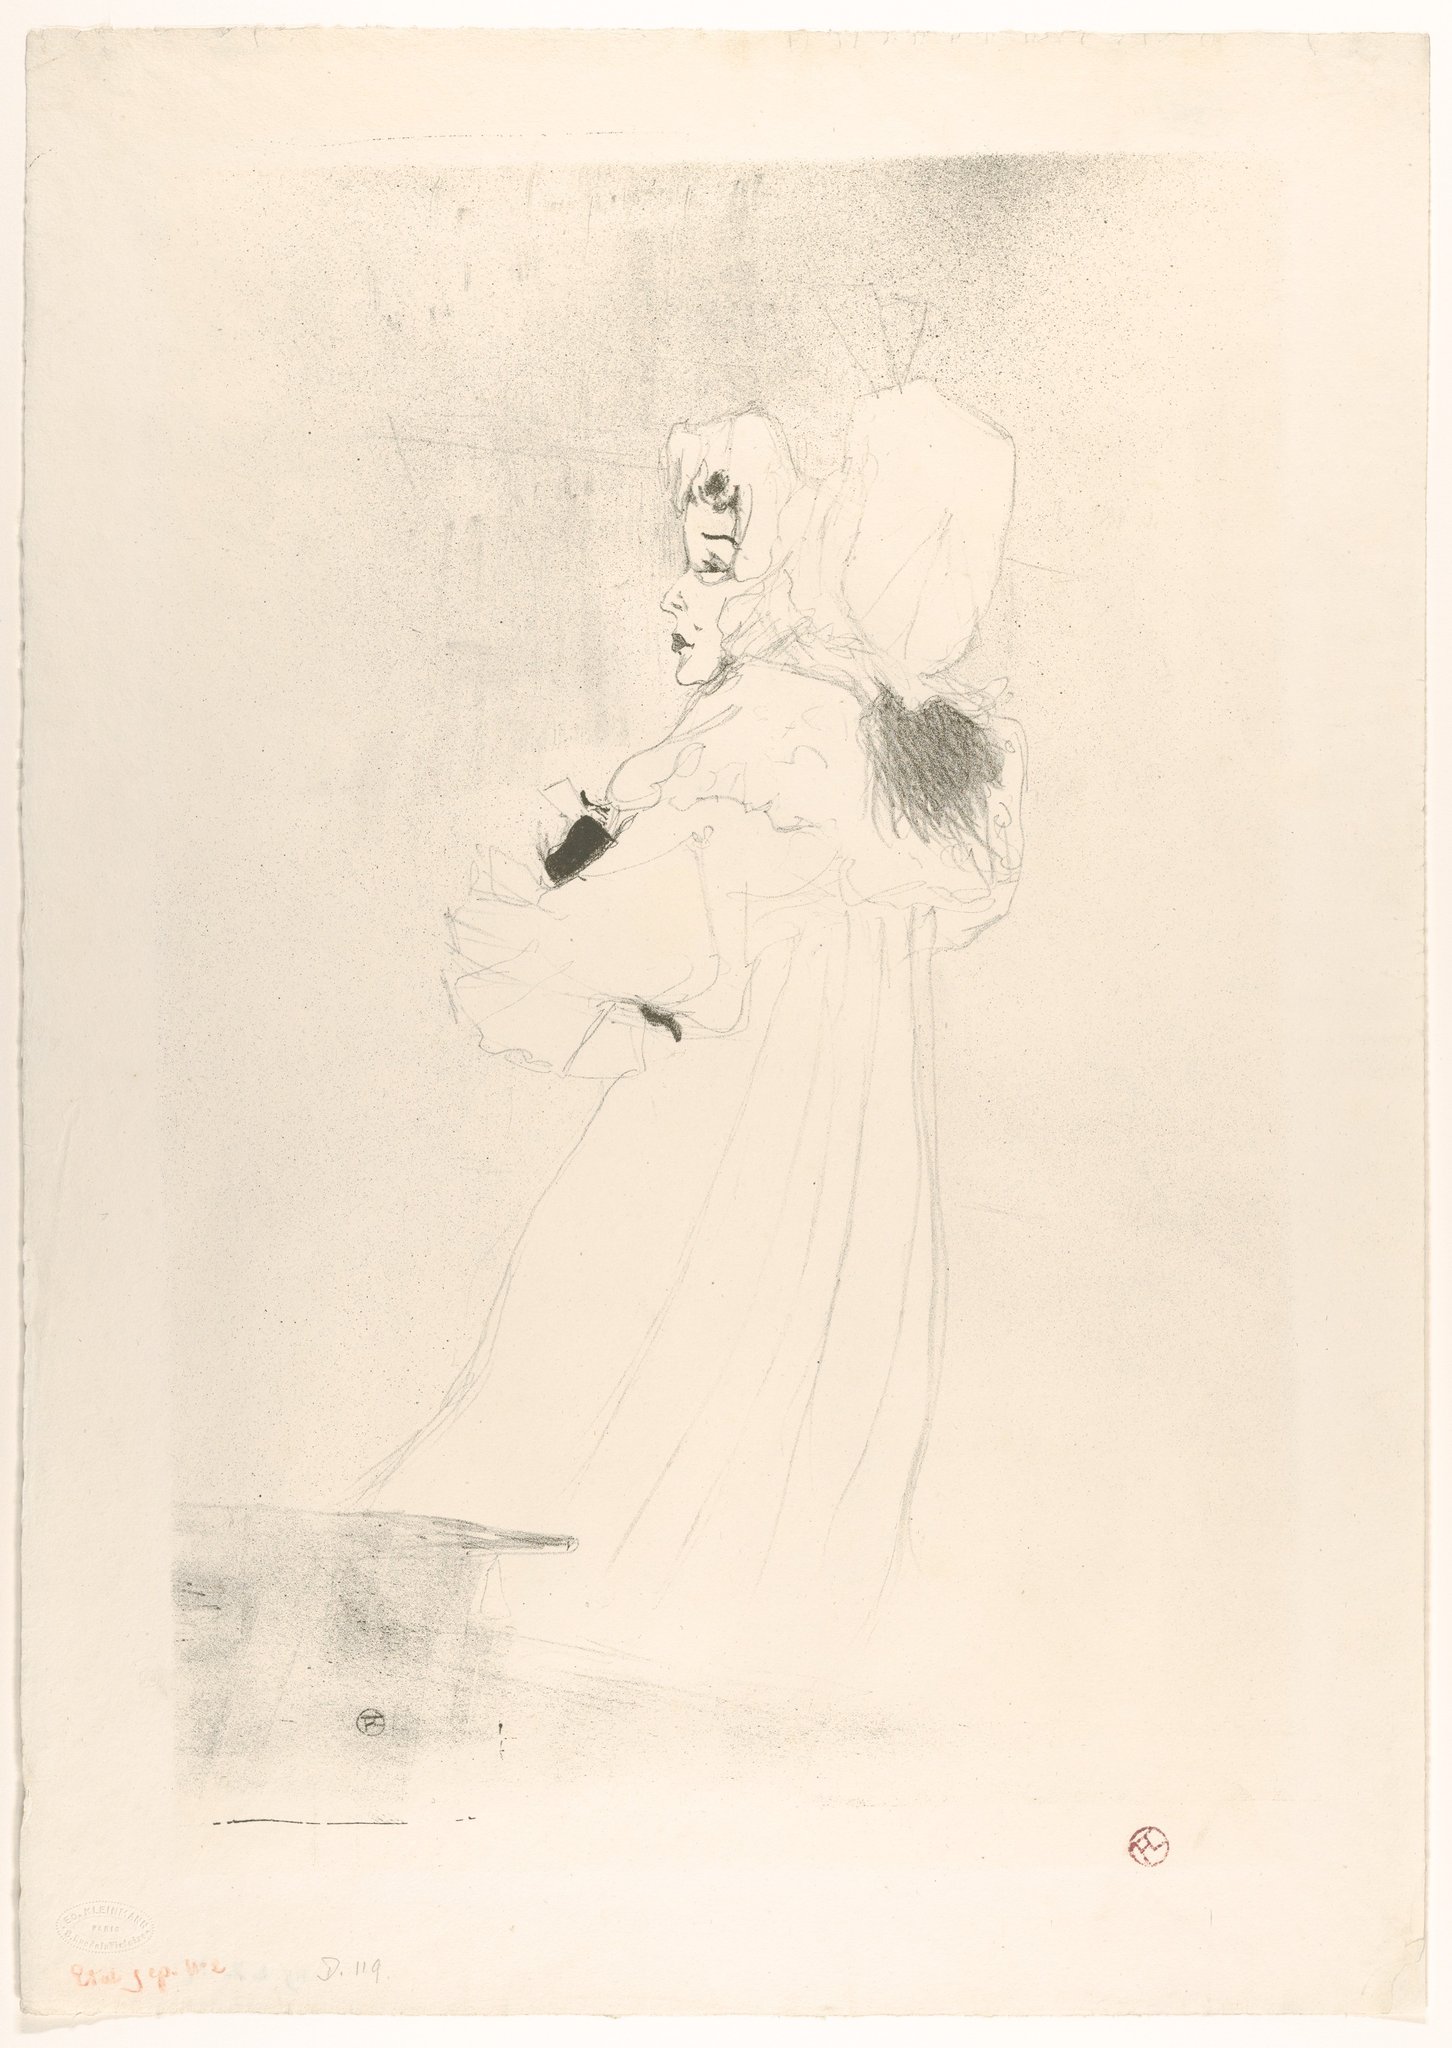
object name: print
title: Miss May Belfort (Large Plate)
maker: henri de toulouse-lautrec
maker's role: artist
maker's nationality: french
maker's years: 1864-1901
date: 1895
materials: crayon, ink, paper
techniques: lithograph, printing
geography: france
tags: women